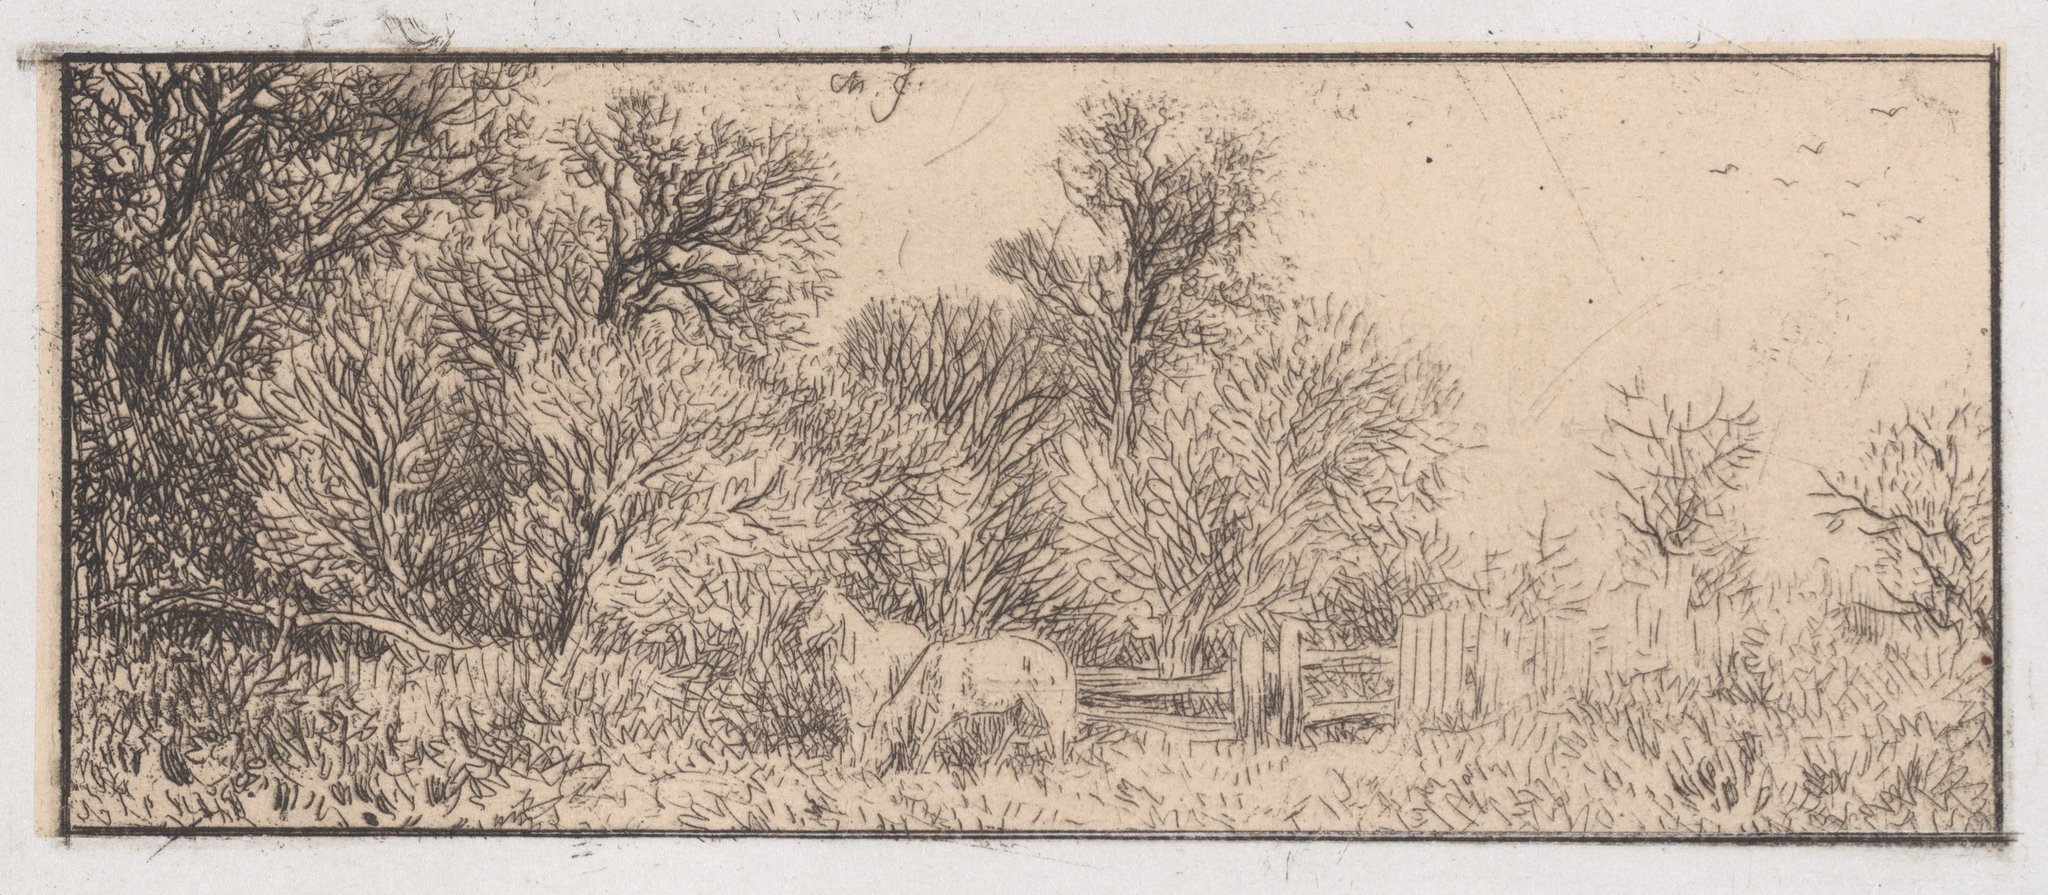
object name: print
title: Two Horses in the Woods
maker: charles émile jacque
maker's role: artist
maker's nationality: french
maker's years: 1813-1894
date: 1845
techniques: etching